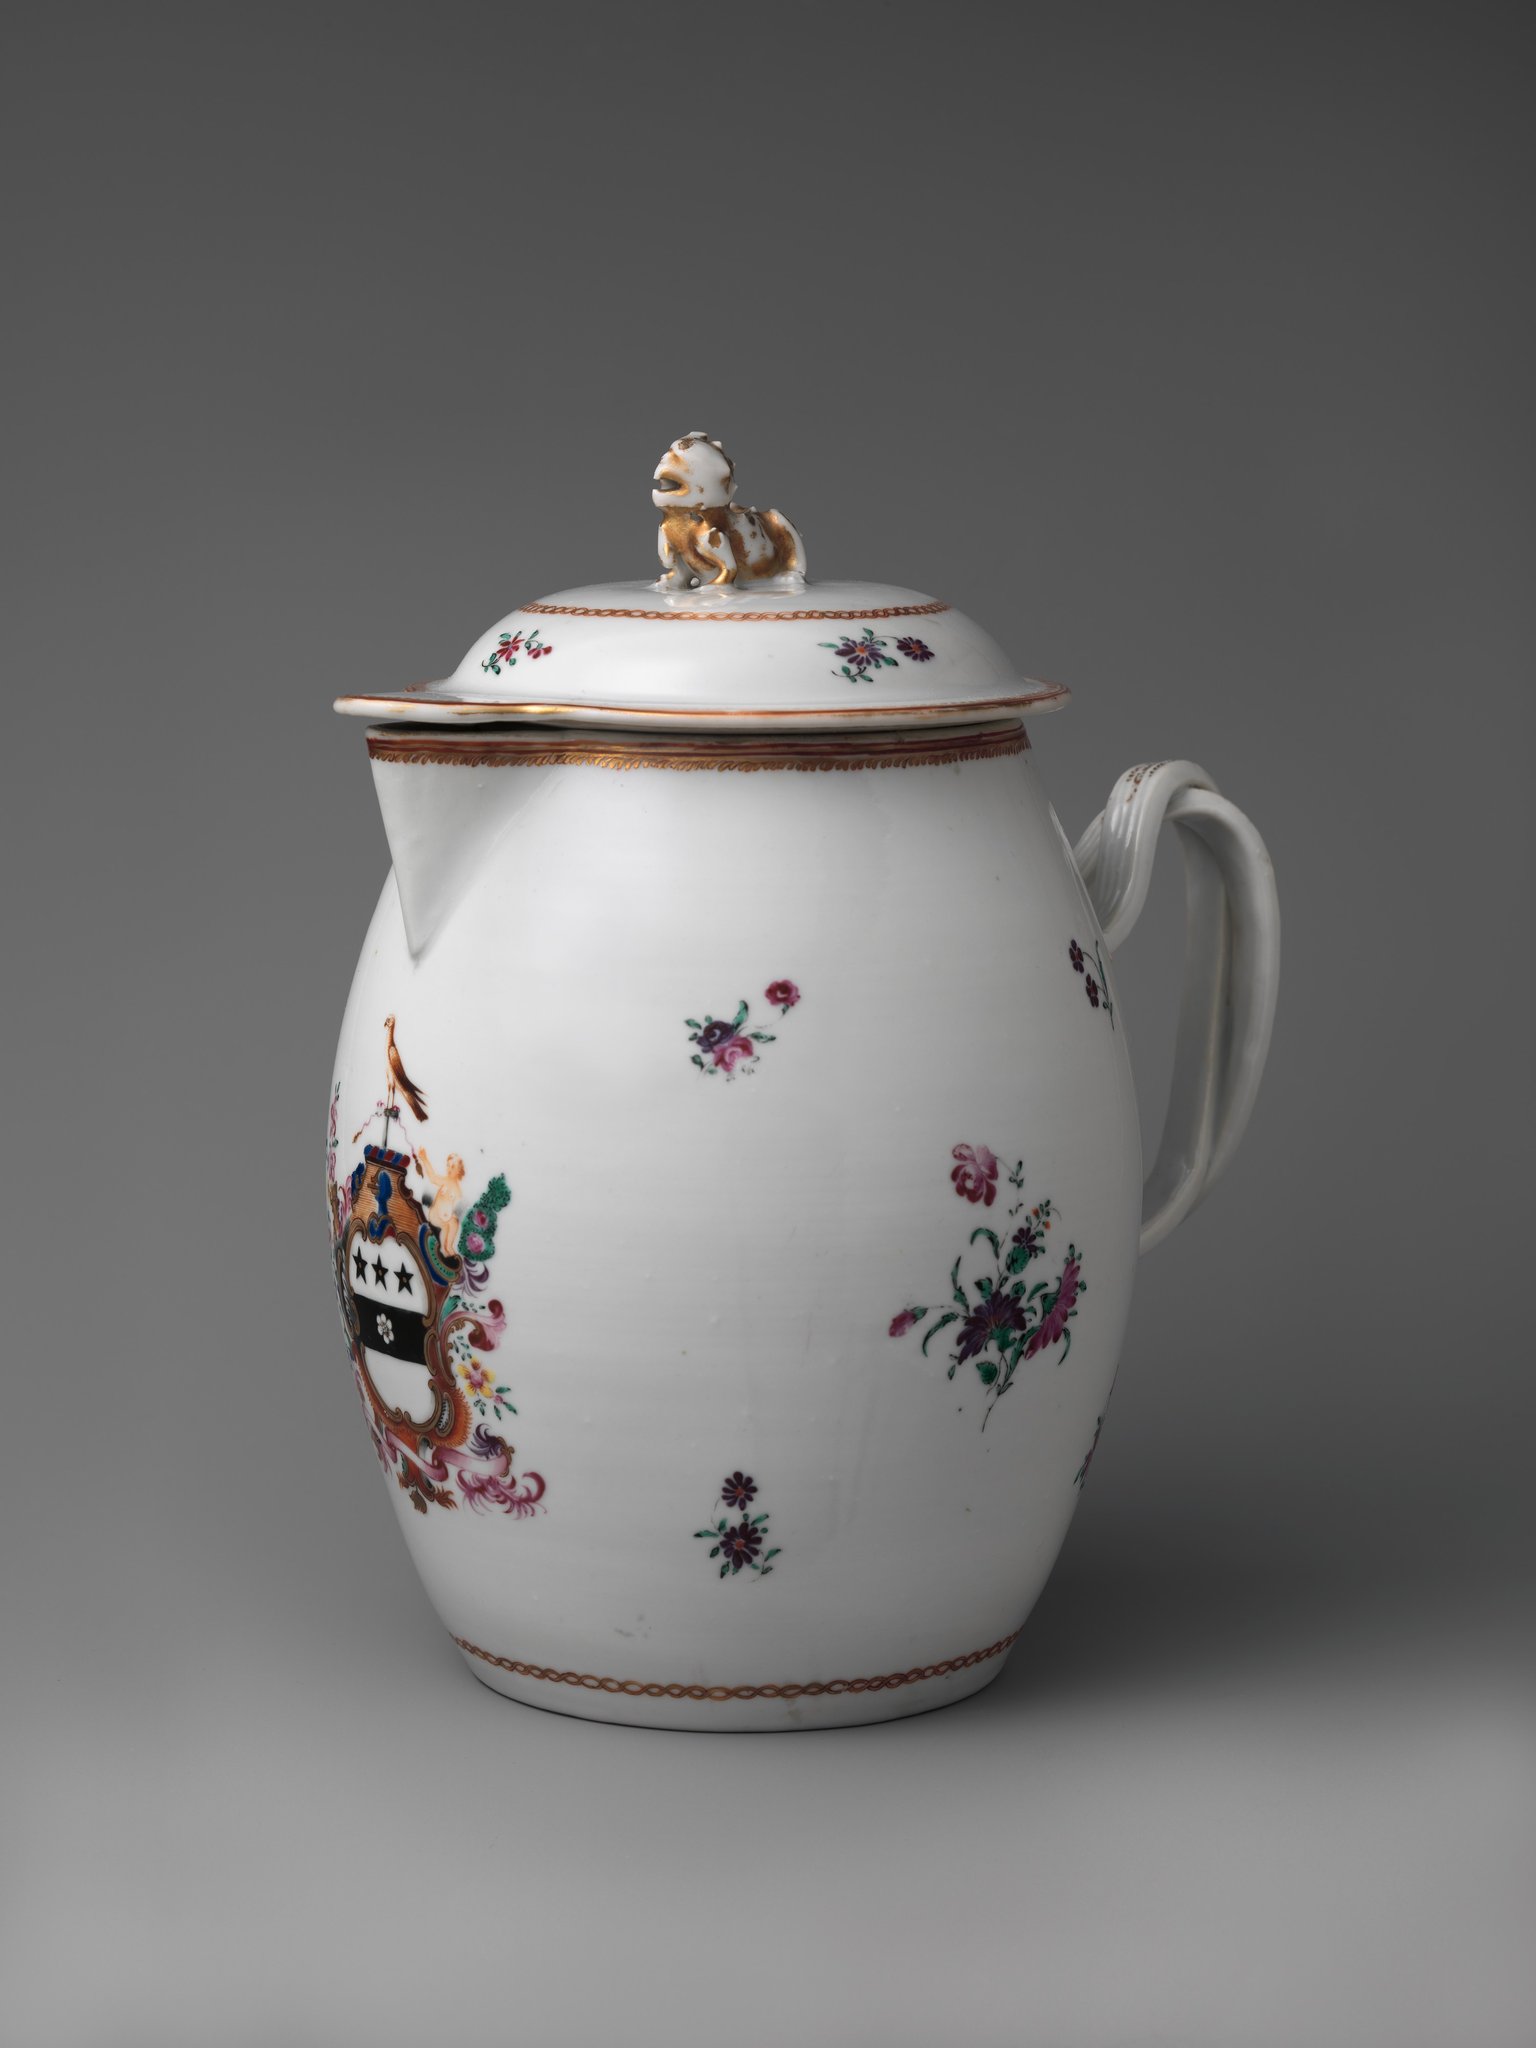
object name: pitcher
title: Covered Pitcher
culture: chinese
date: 1785-1790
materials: porcelain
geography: china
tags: birds,coat of arms